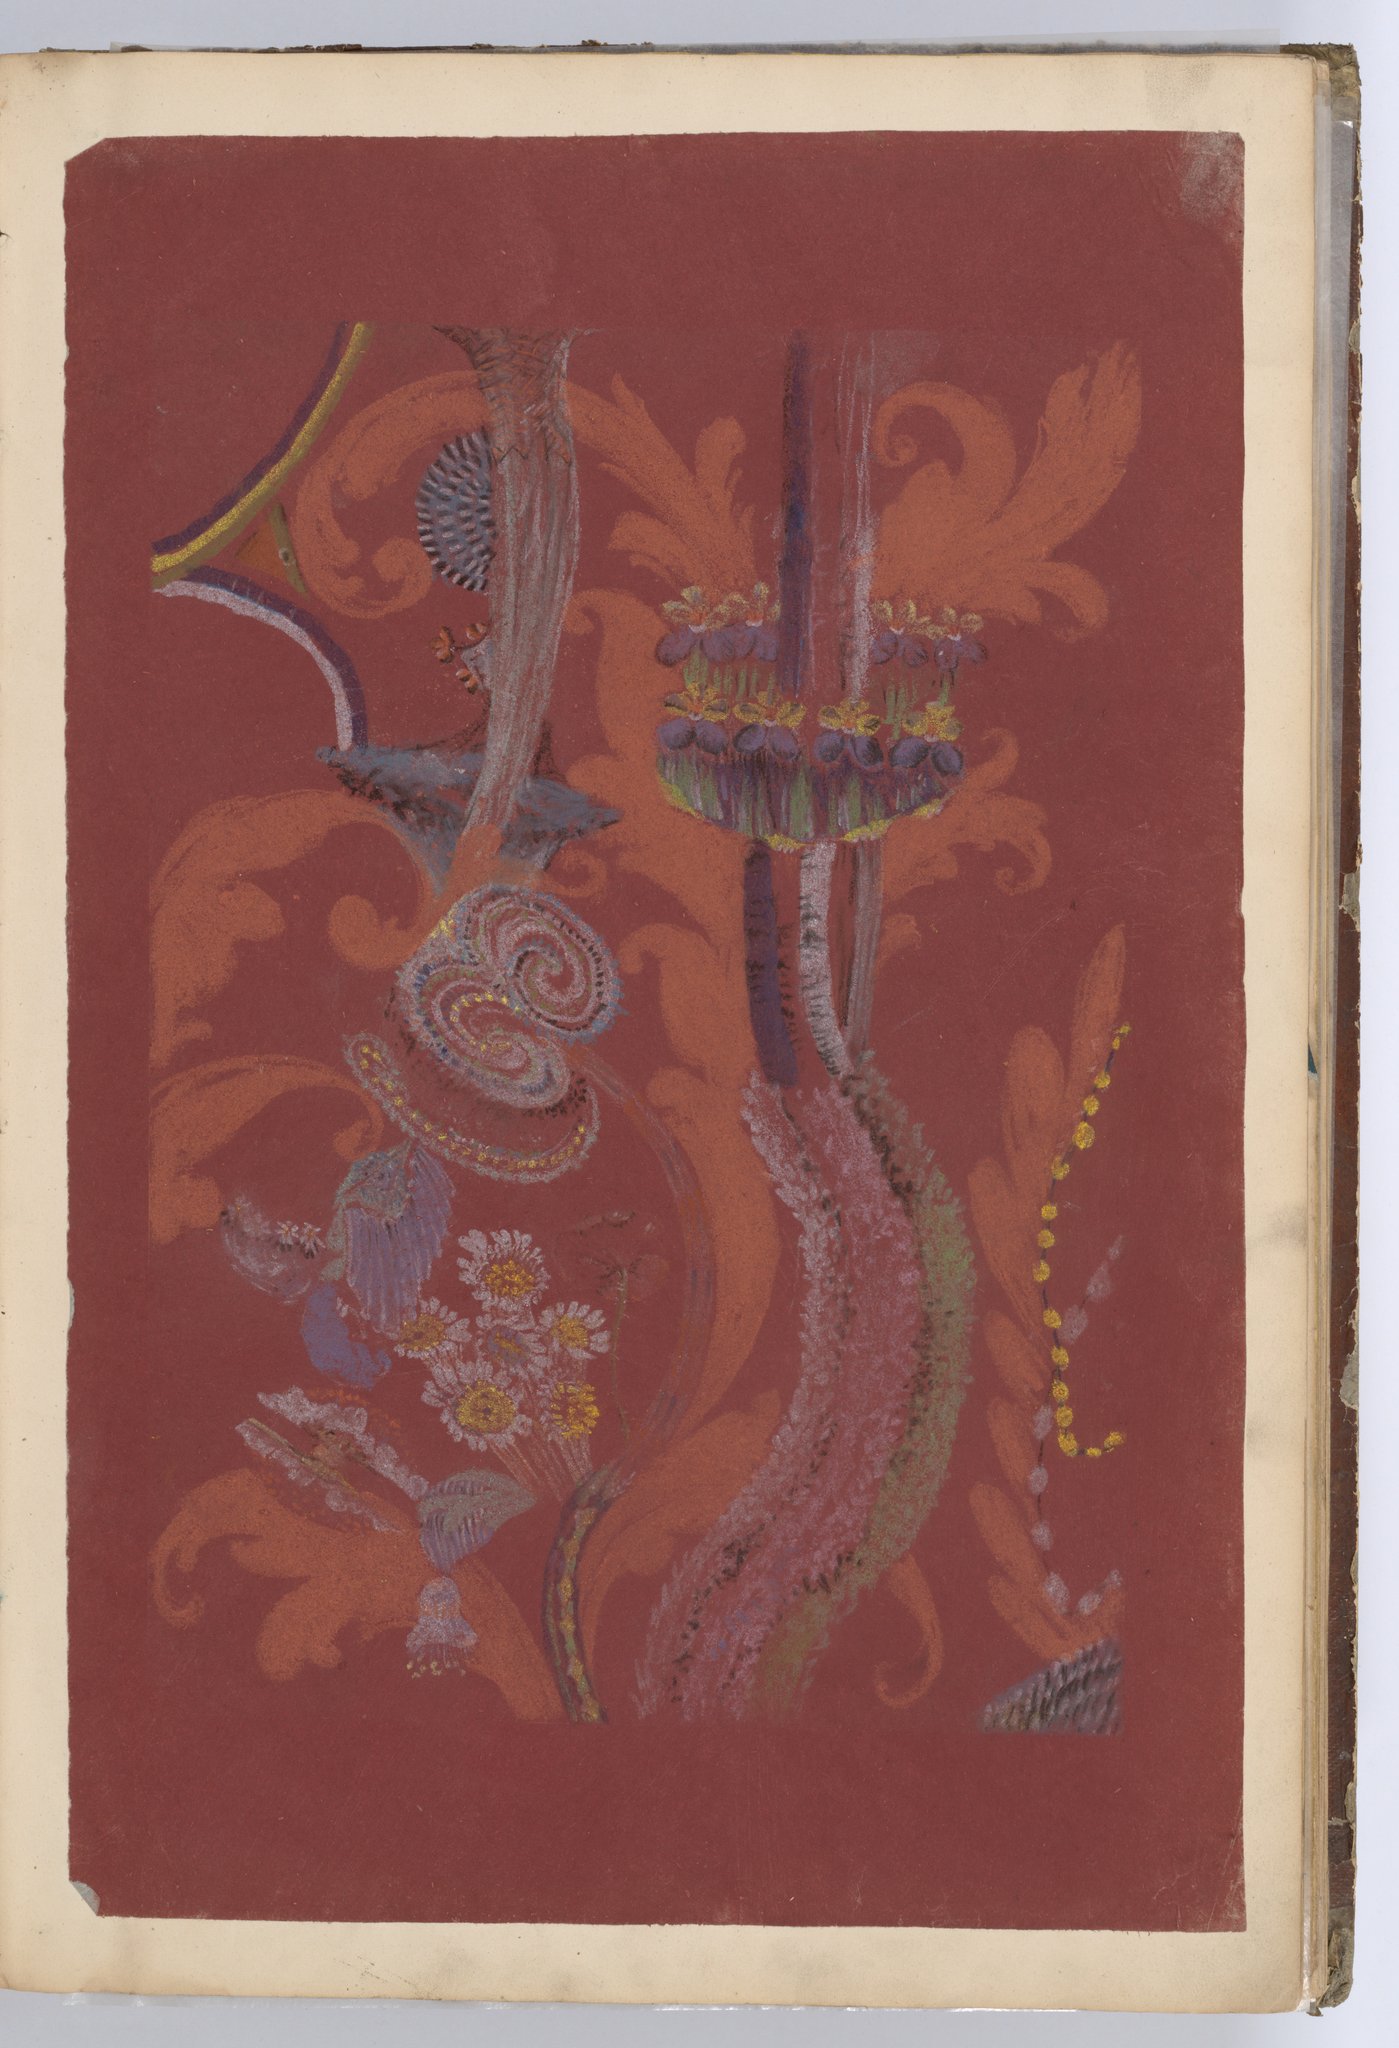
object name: album print ornament architecture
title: Scrapbook with Textile Designs on Colored Papers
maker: anonymous, french, 19th century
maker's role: artist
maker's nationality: french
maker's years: 1800-1900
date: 1801-1900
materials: paper, pastel